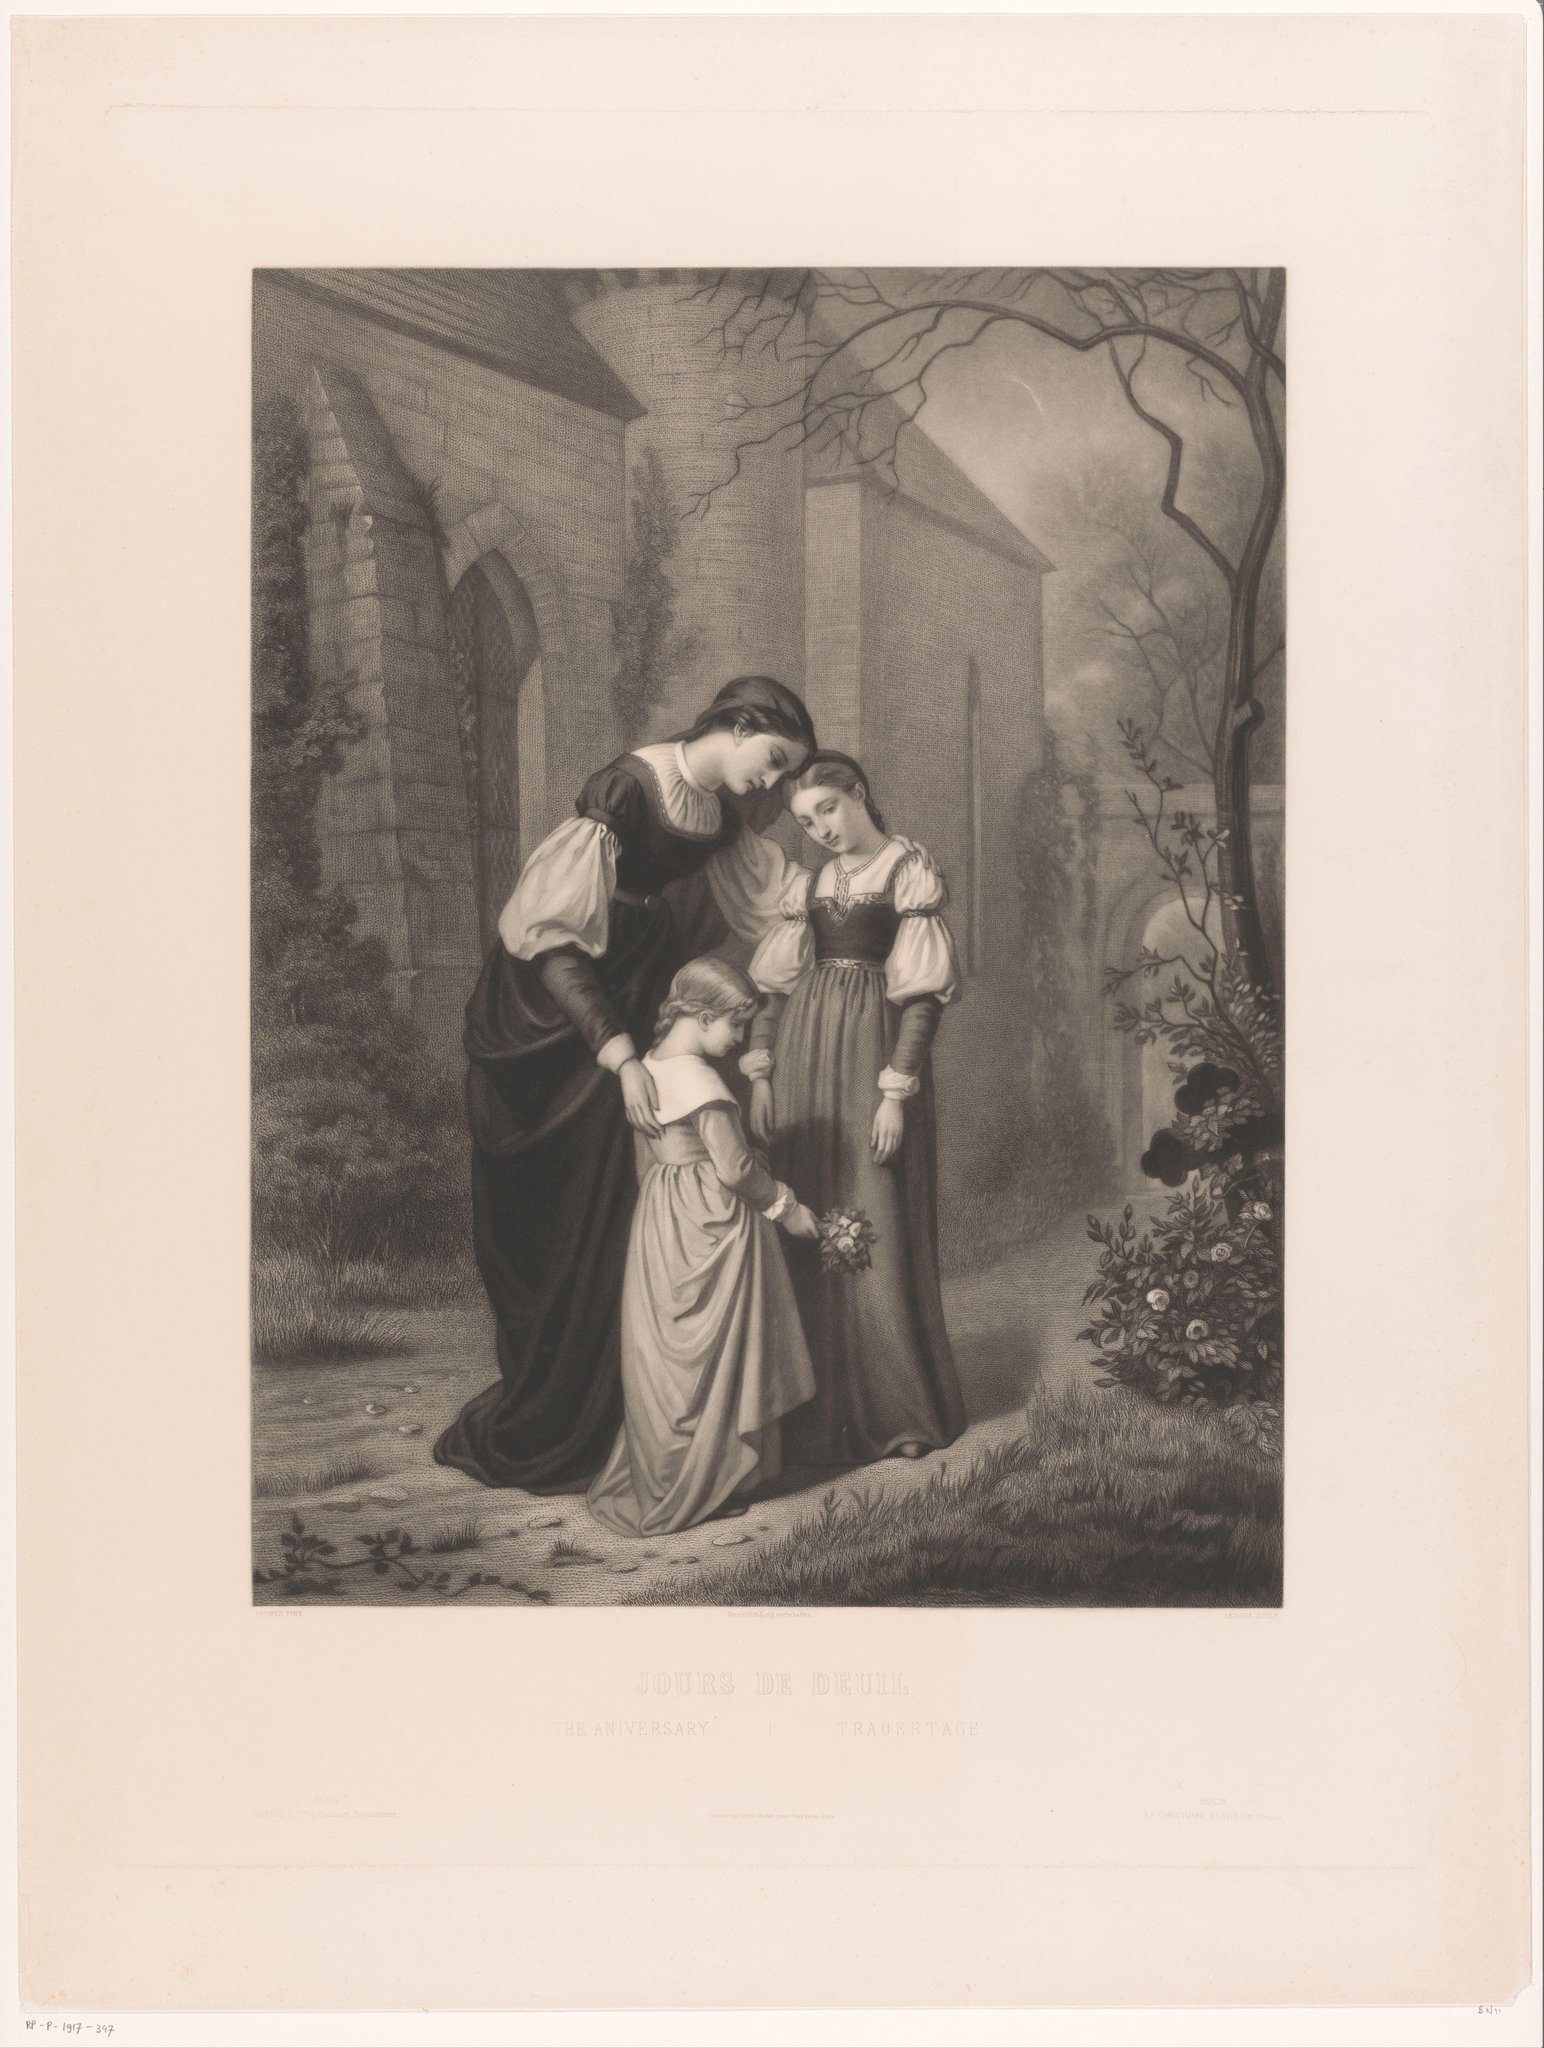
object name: print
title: Jours de Deuil / The Aniversary / Trauertage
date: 1866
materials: paper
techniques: aquatint, etching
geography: paris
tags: mourning customs, churchyard, cemetery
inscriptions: : ‘Vervielfältigung vorbehalten.’, collector's mark: Lugt 2228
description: Betreft een pendant van een prent met de titel 'Jours de fête'.